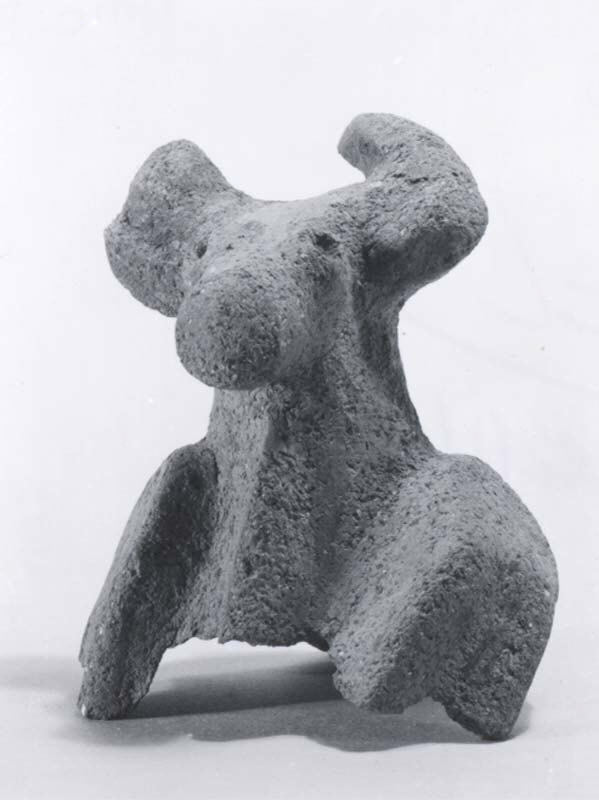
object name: sculpture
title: Bull's head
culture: iranian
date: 900-801 BCE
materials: ceramic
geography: iran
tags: bulls